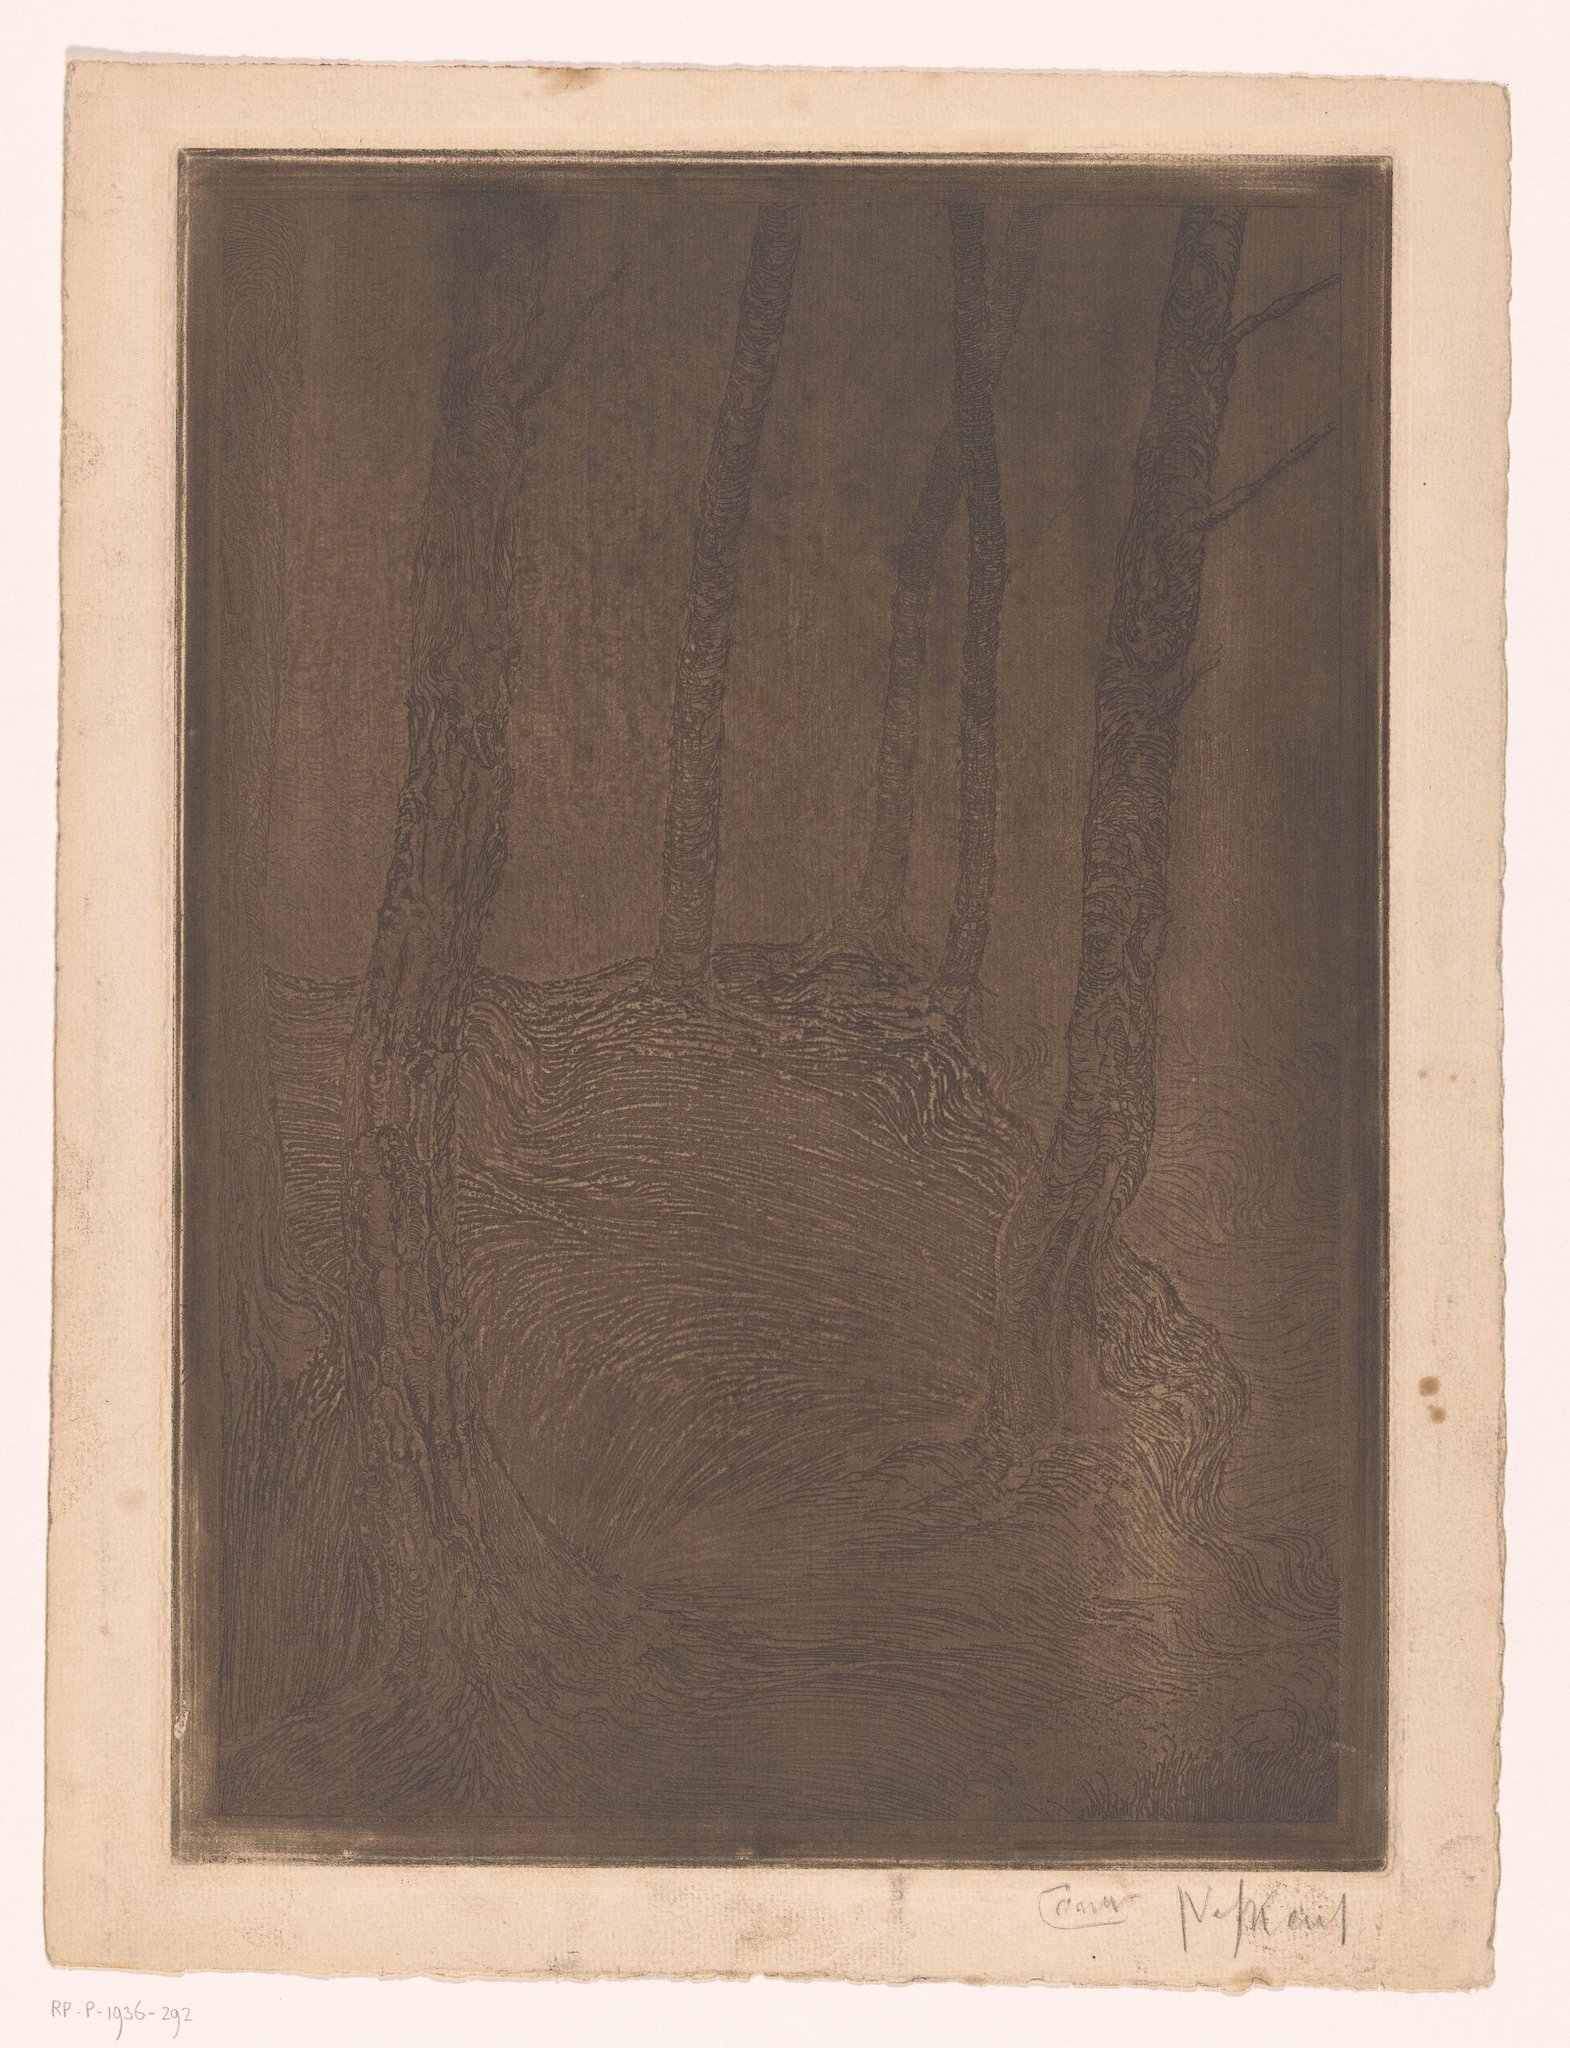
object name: print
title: Bosrand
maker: martinus josephus nefkens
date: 1876-1936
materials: paper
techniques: etching, intaglio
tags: fringe, edge of the wood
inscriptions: collector's mark: Lugt 2228